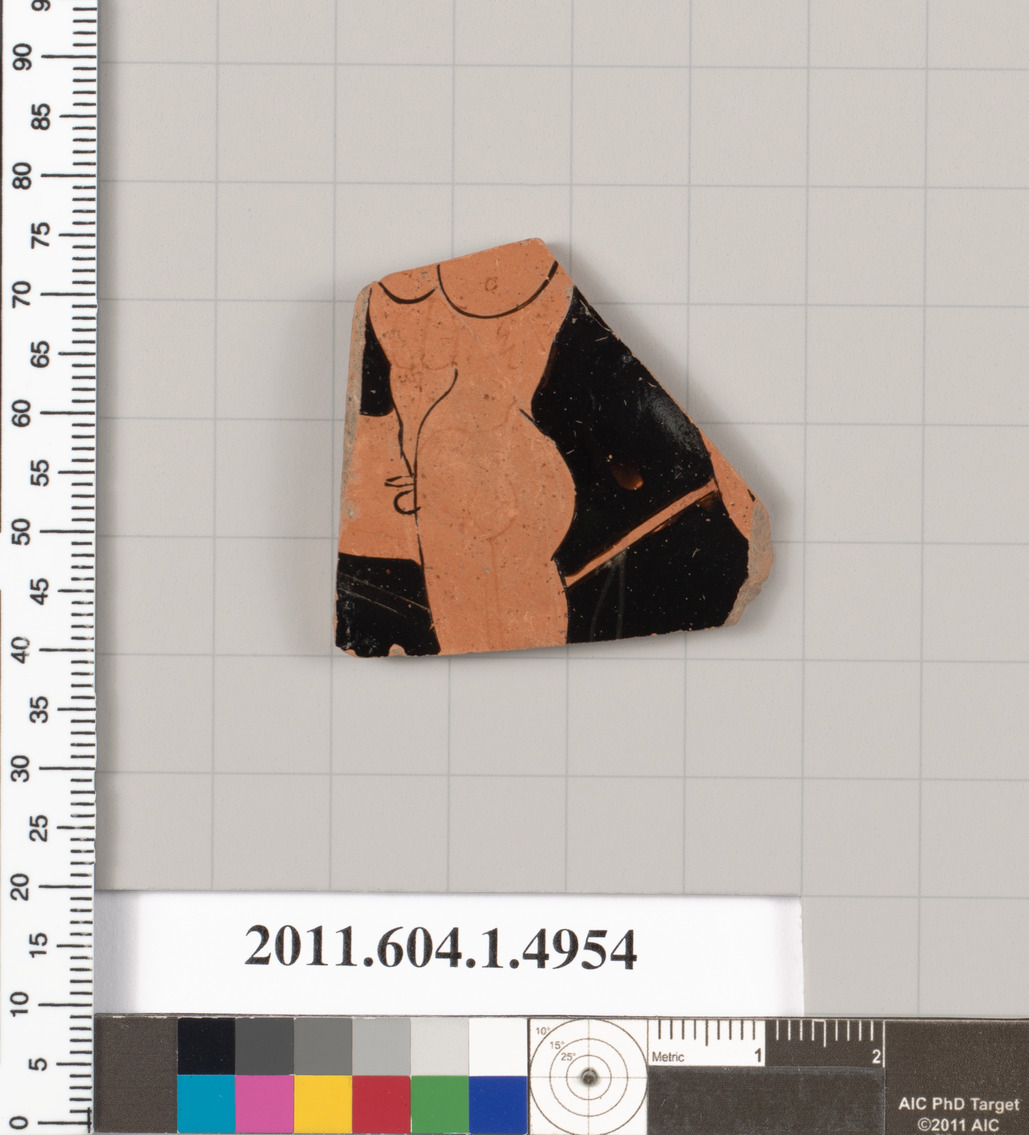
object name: kylix fragment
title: Terracotta fragment of a kylix (drinking cup)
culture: greek, attic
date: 500-480 BCE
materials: terracotta